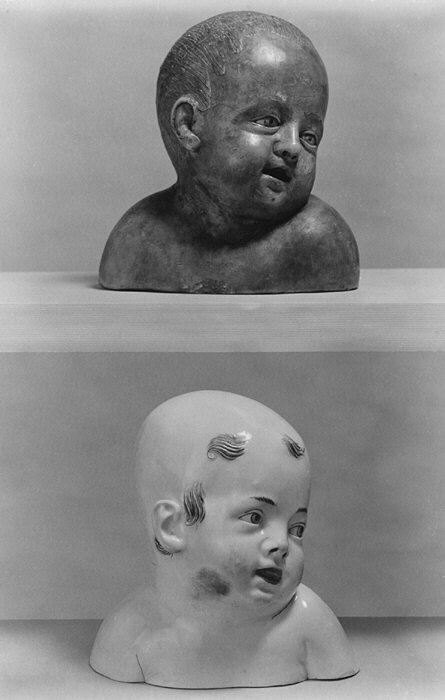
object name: model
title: Wax model for the bust of a child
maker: meissen manufactory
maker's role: manufactory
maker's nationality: german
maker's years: 1710-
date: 1715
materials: wax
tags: faces,infants